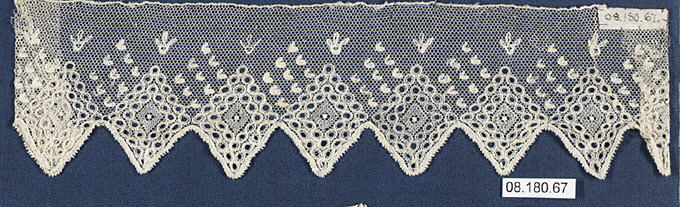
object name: fragment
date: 1801-1900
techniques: lace